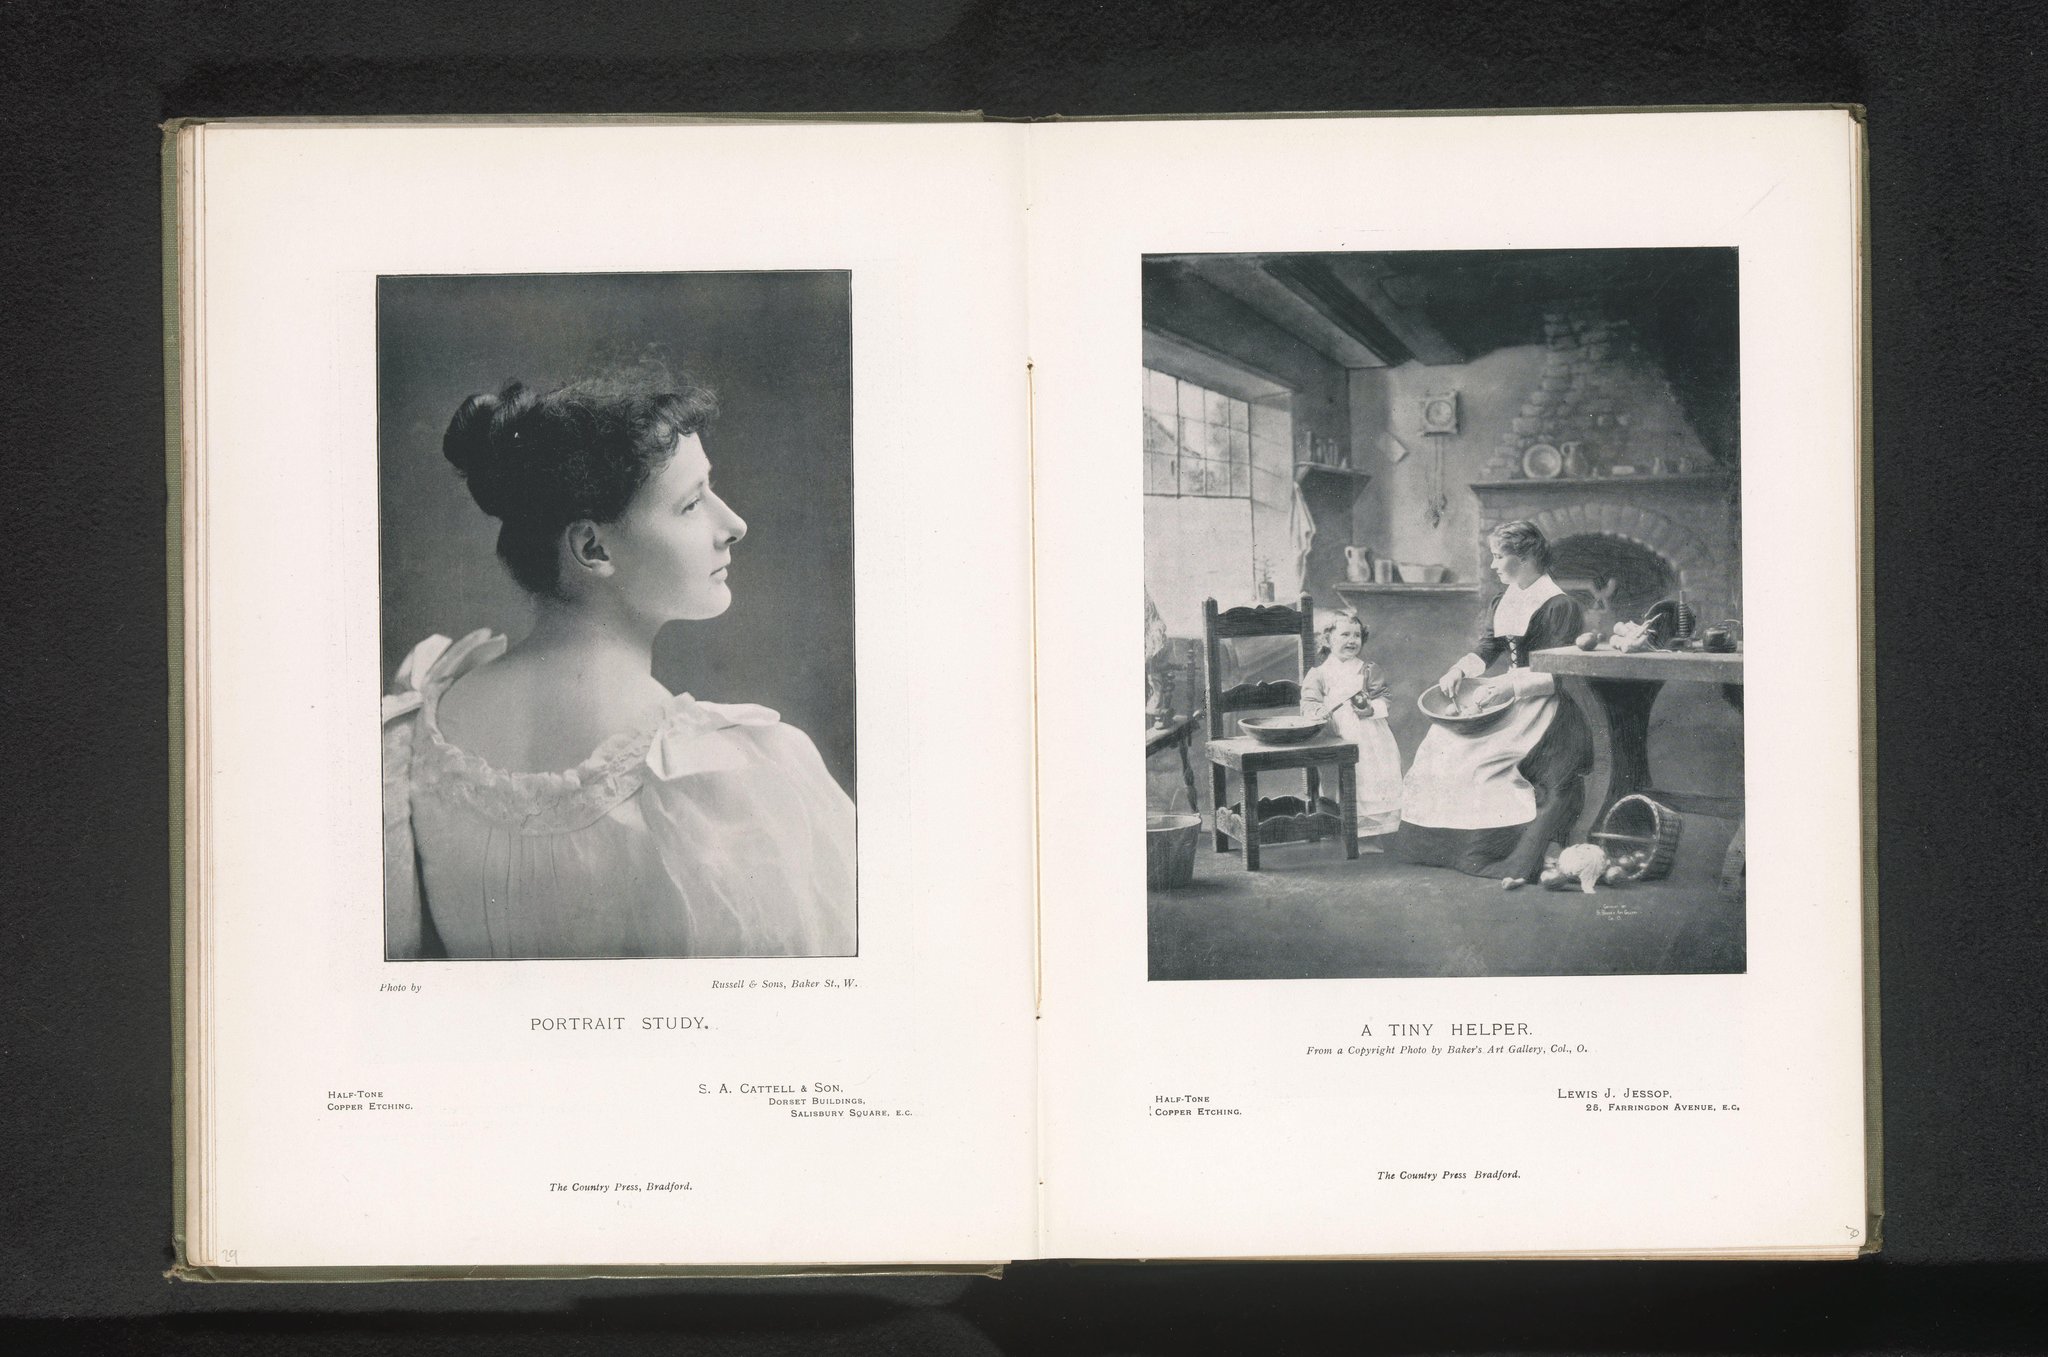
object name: photomechanical print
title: Twee meisjes in de keuken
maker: lewis j. jessop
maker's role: clichémaker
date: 1893-1898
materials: paper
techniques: autotype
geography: london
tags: kitchen, girl (child between toddler and youth)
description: Prent op vijfde ongenummerde pagina na pagina 28.